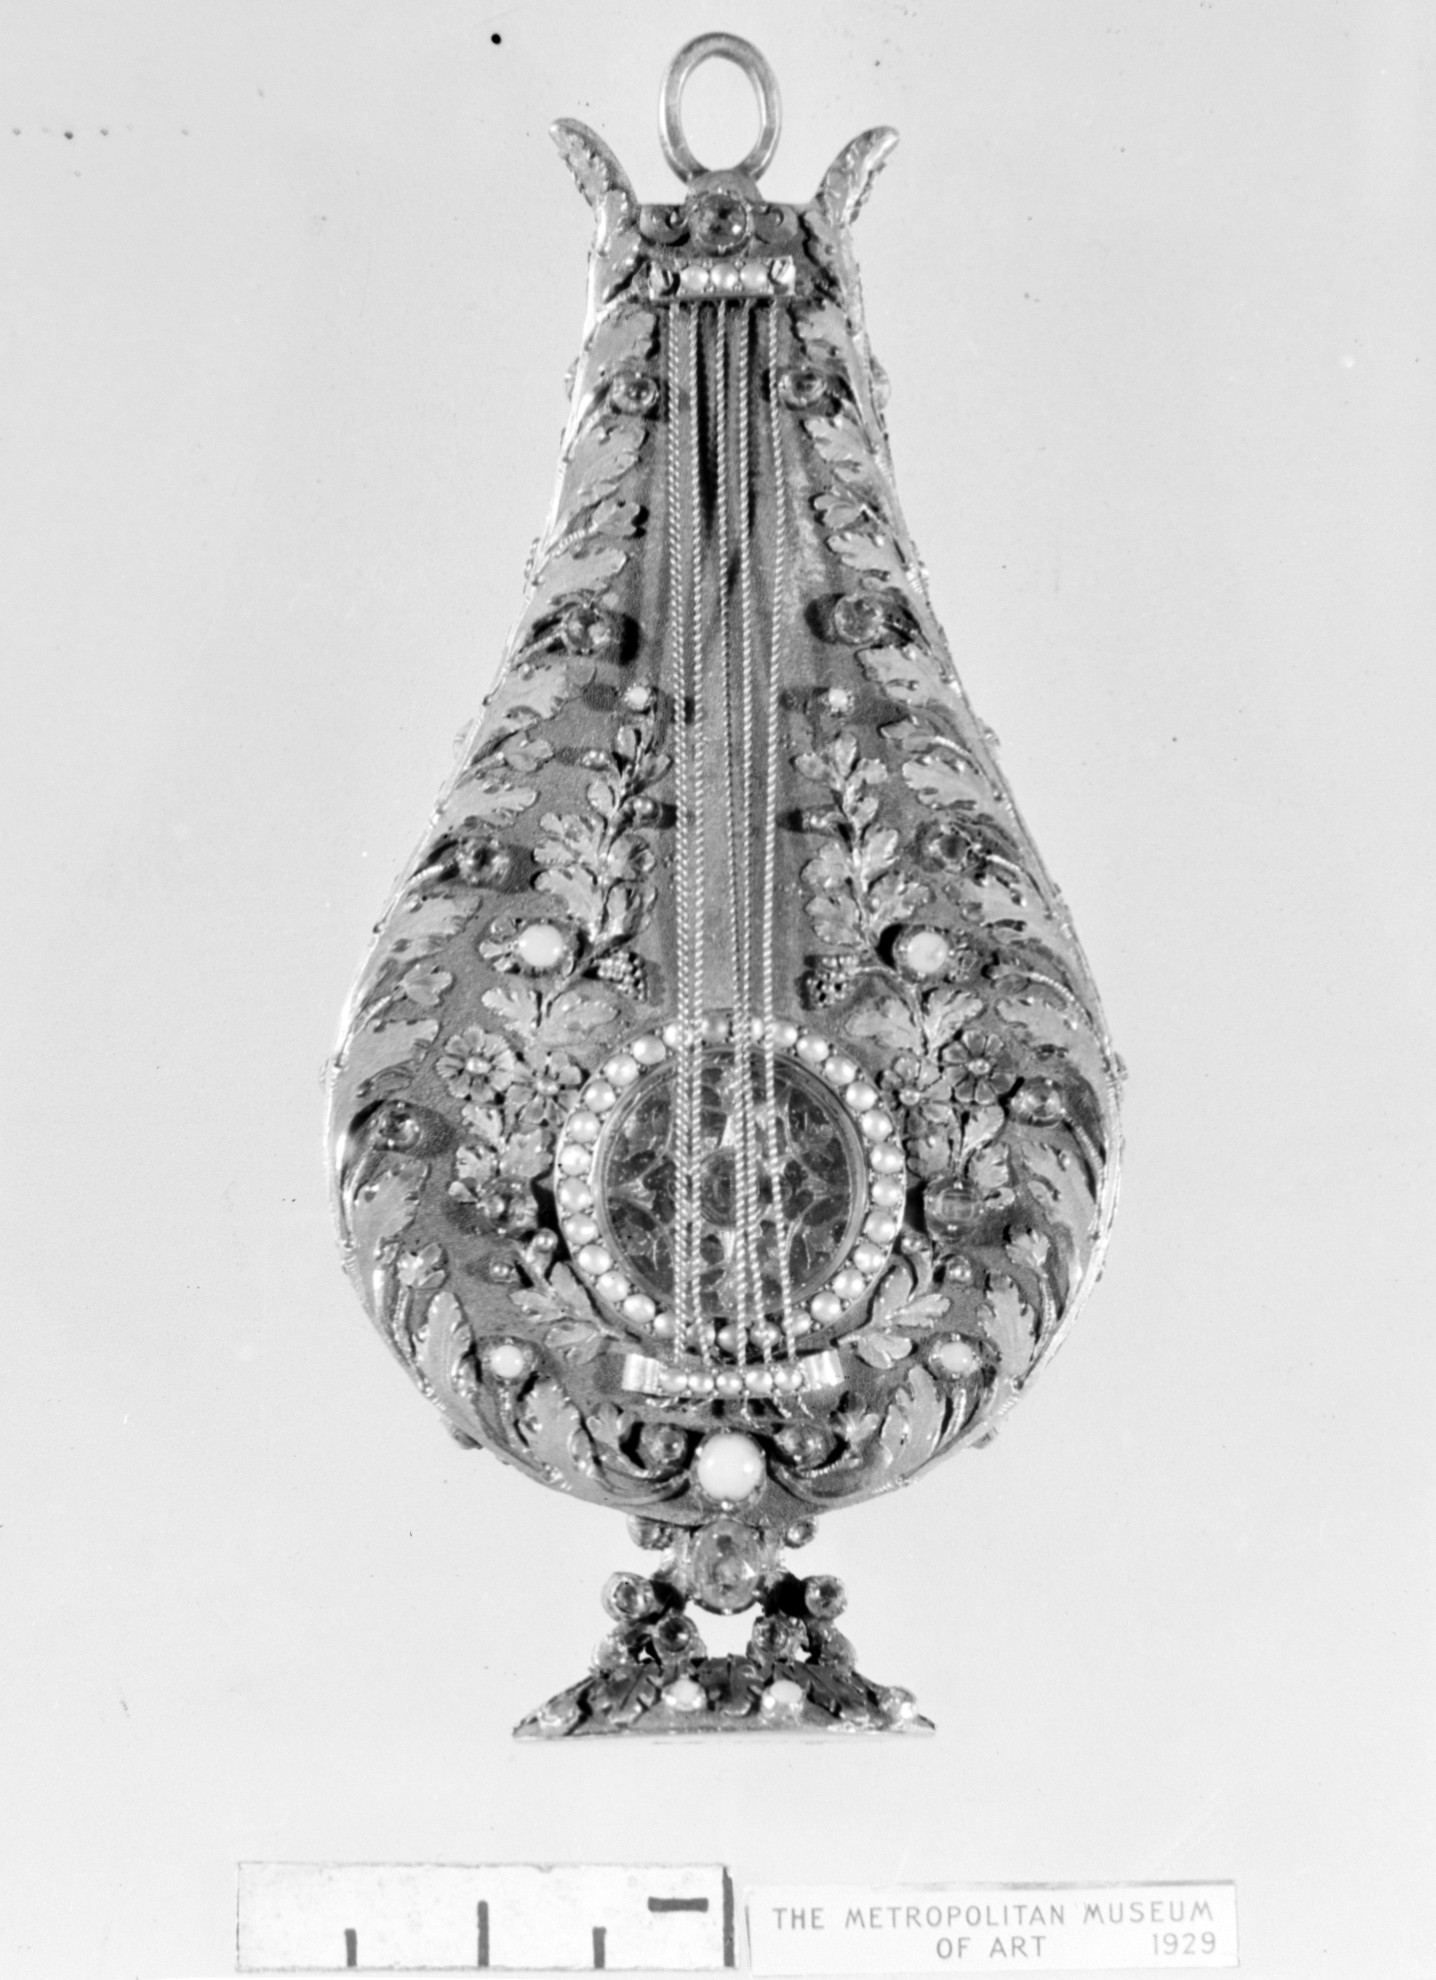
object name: watch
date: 1801-1900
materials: gemstone, enamel, gold, pearl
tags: flowers